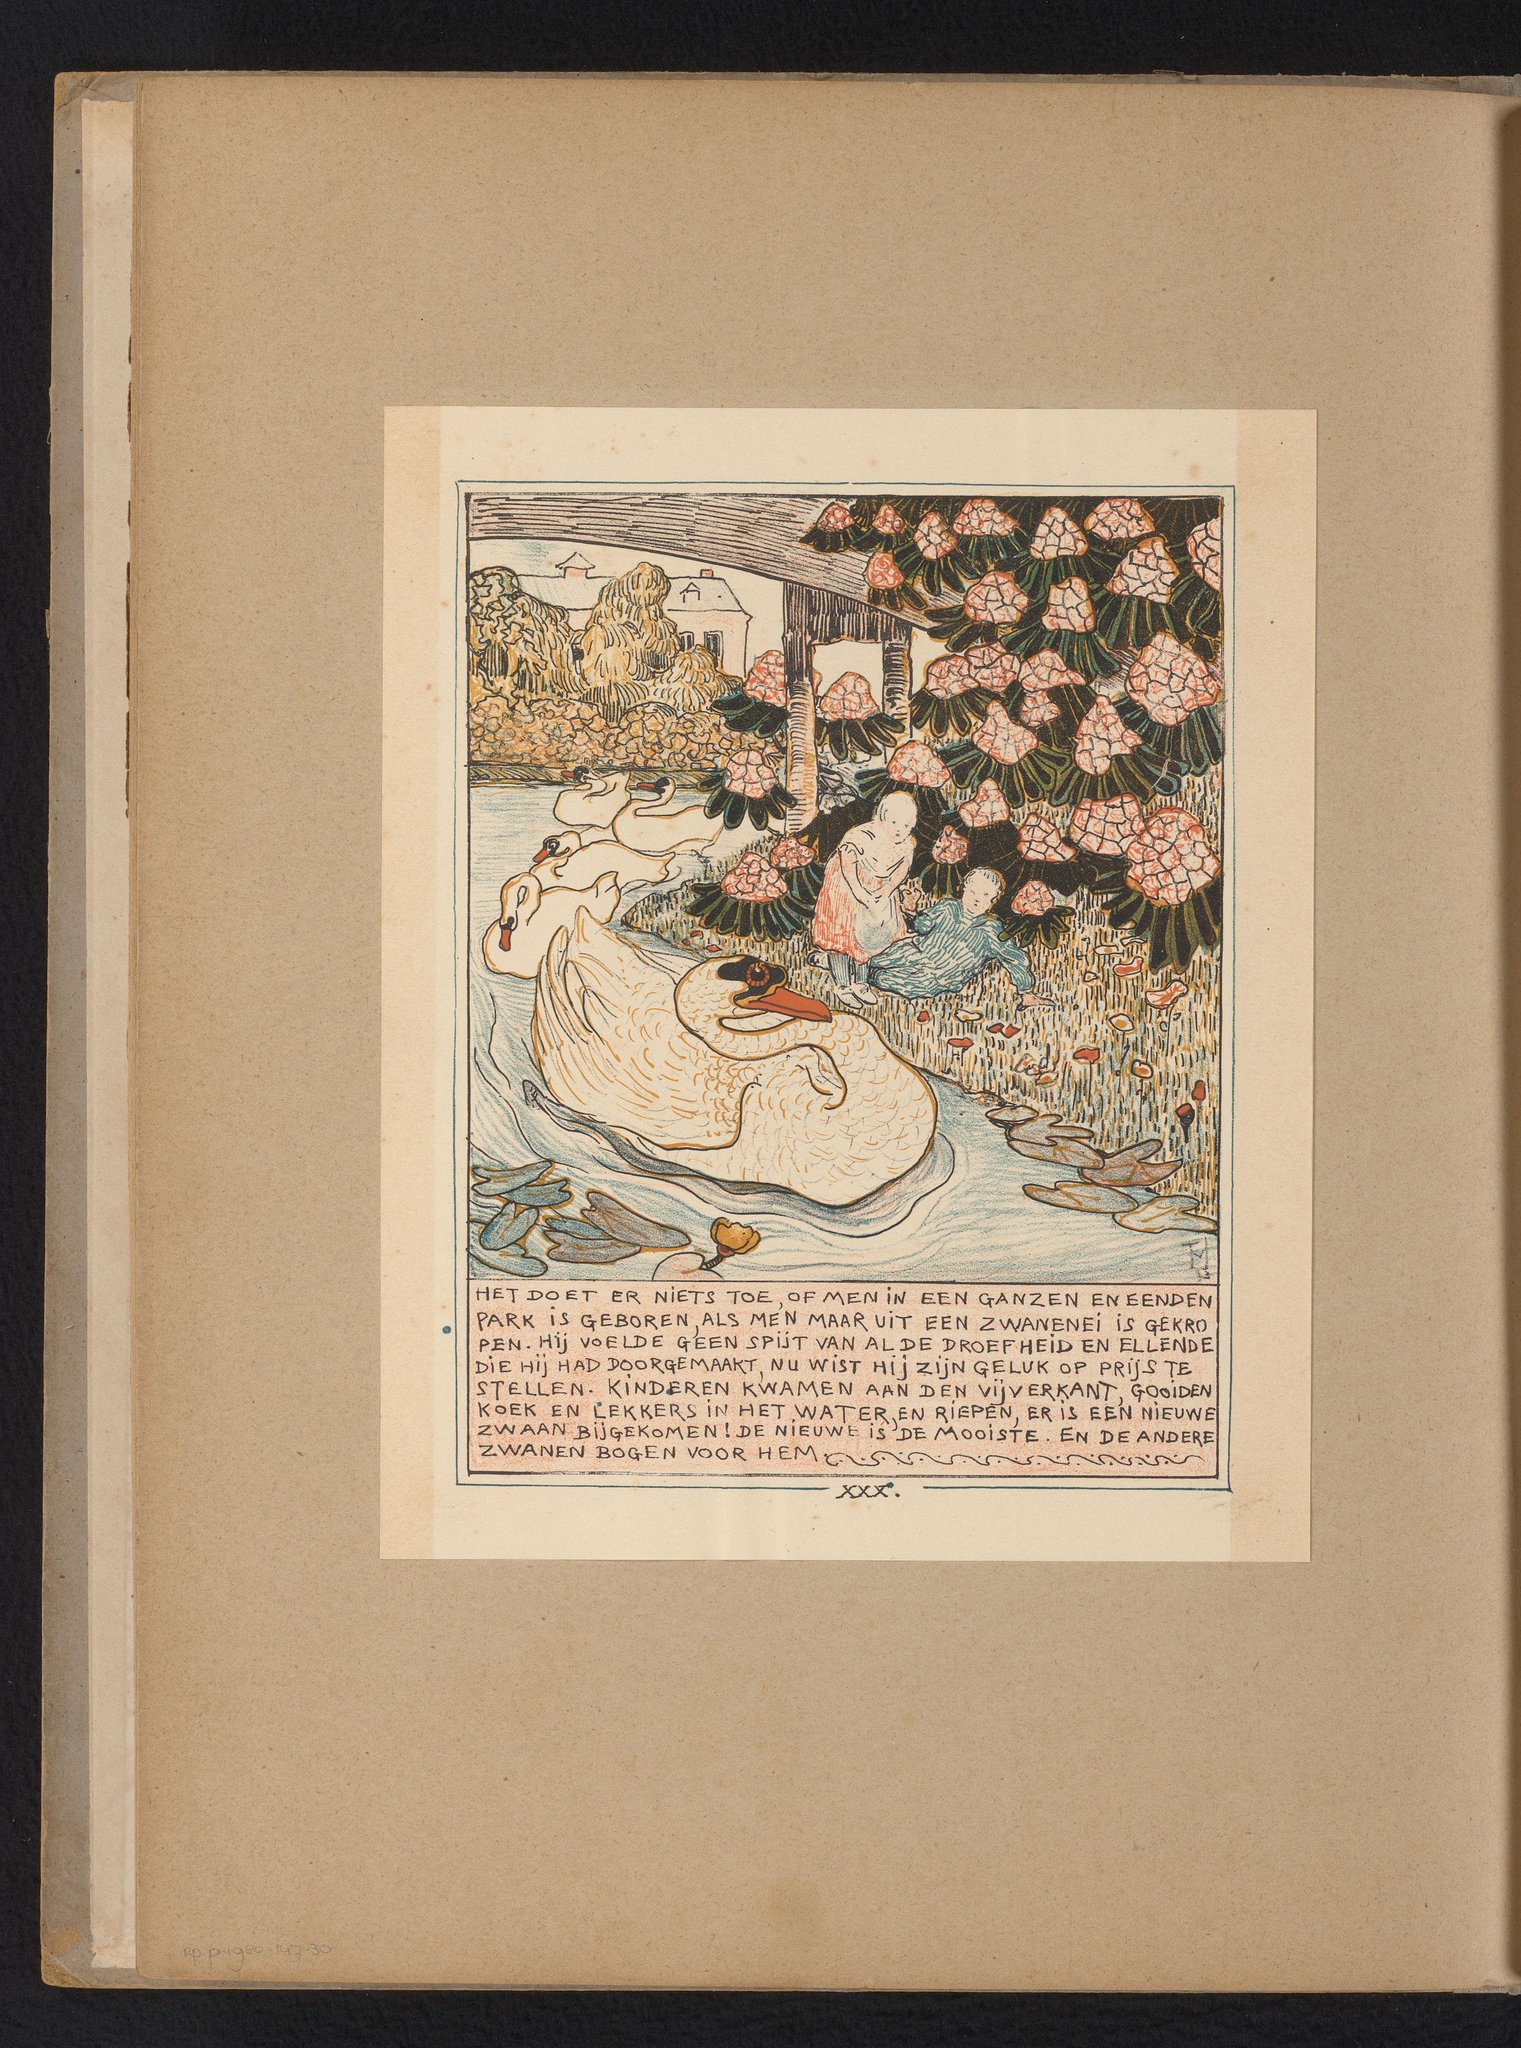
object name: print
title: Twee kinderen op de kant voeren langszwemmende zwanen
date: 1893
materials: paper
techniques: lithograph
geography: amsterdam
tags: water-birds: swan, feeding wild animals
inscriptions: date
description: Deze prent maakt deel uit van een album.